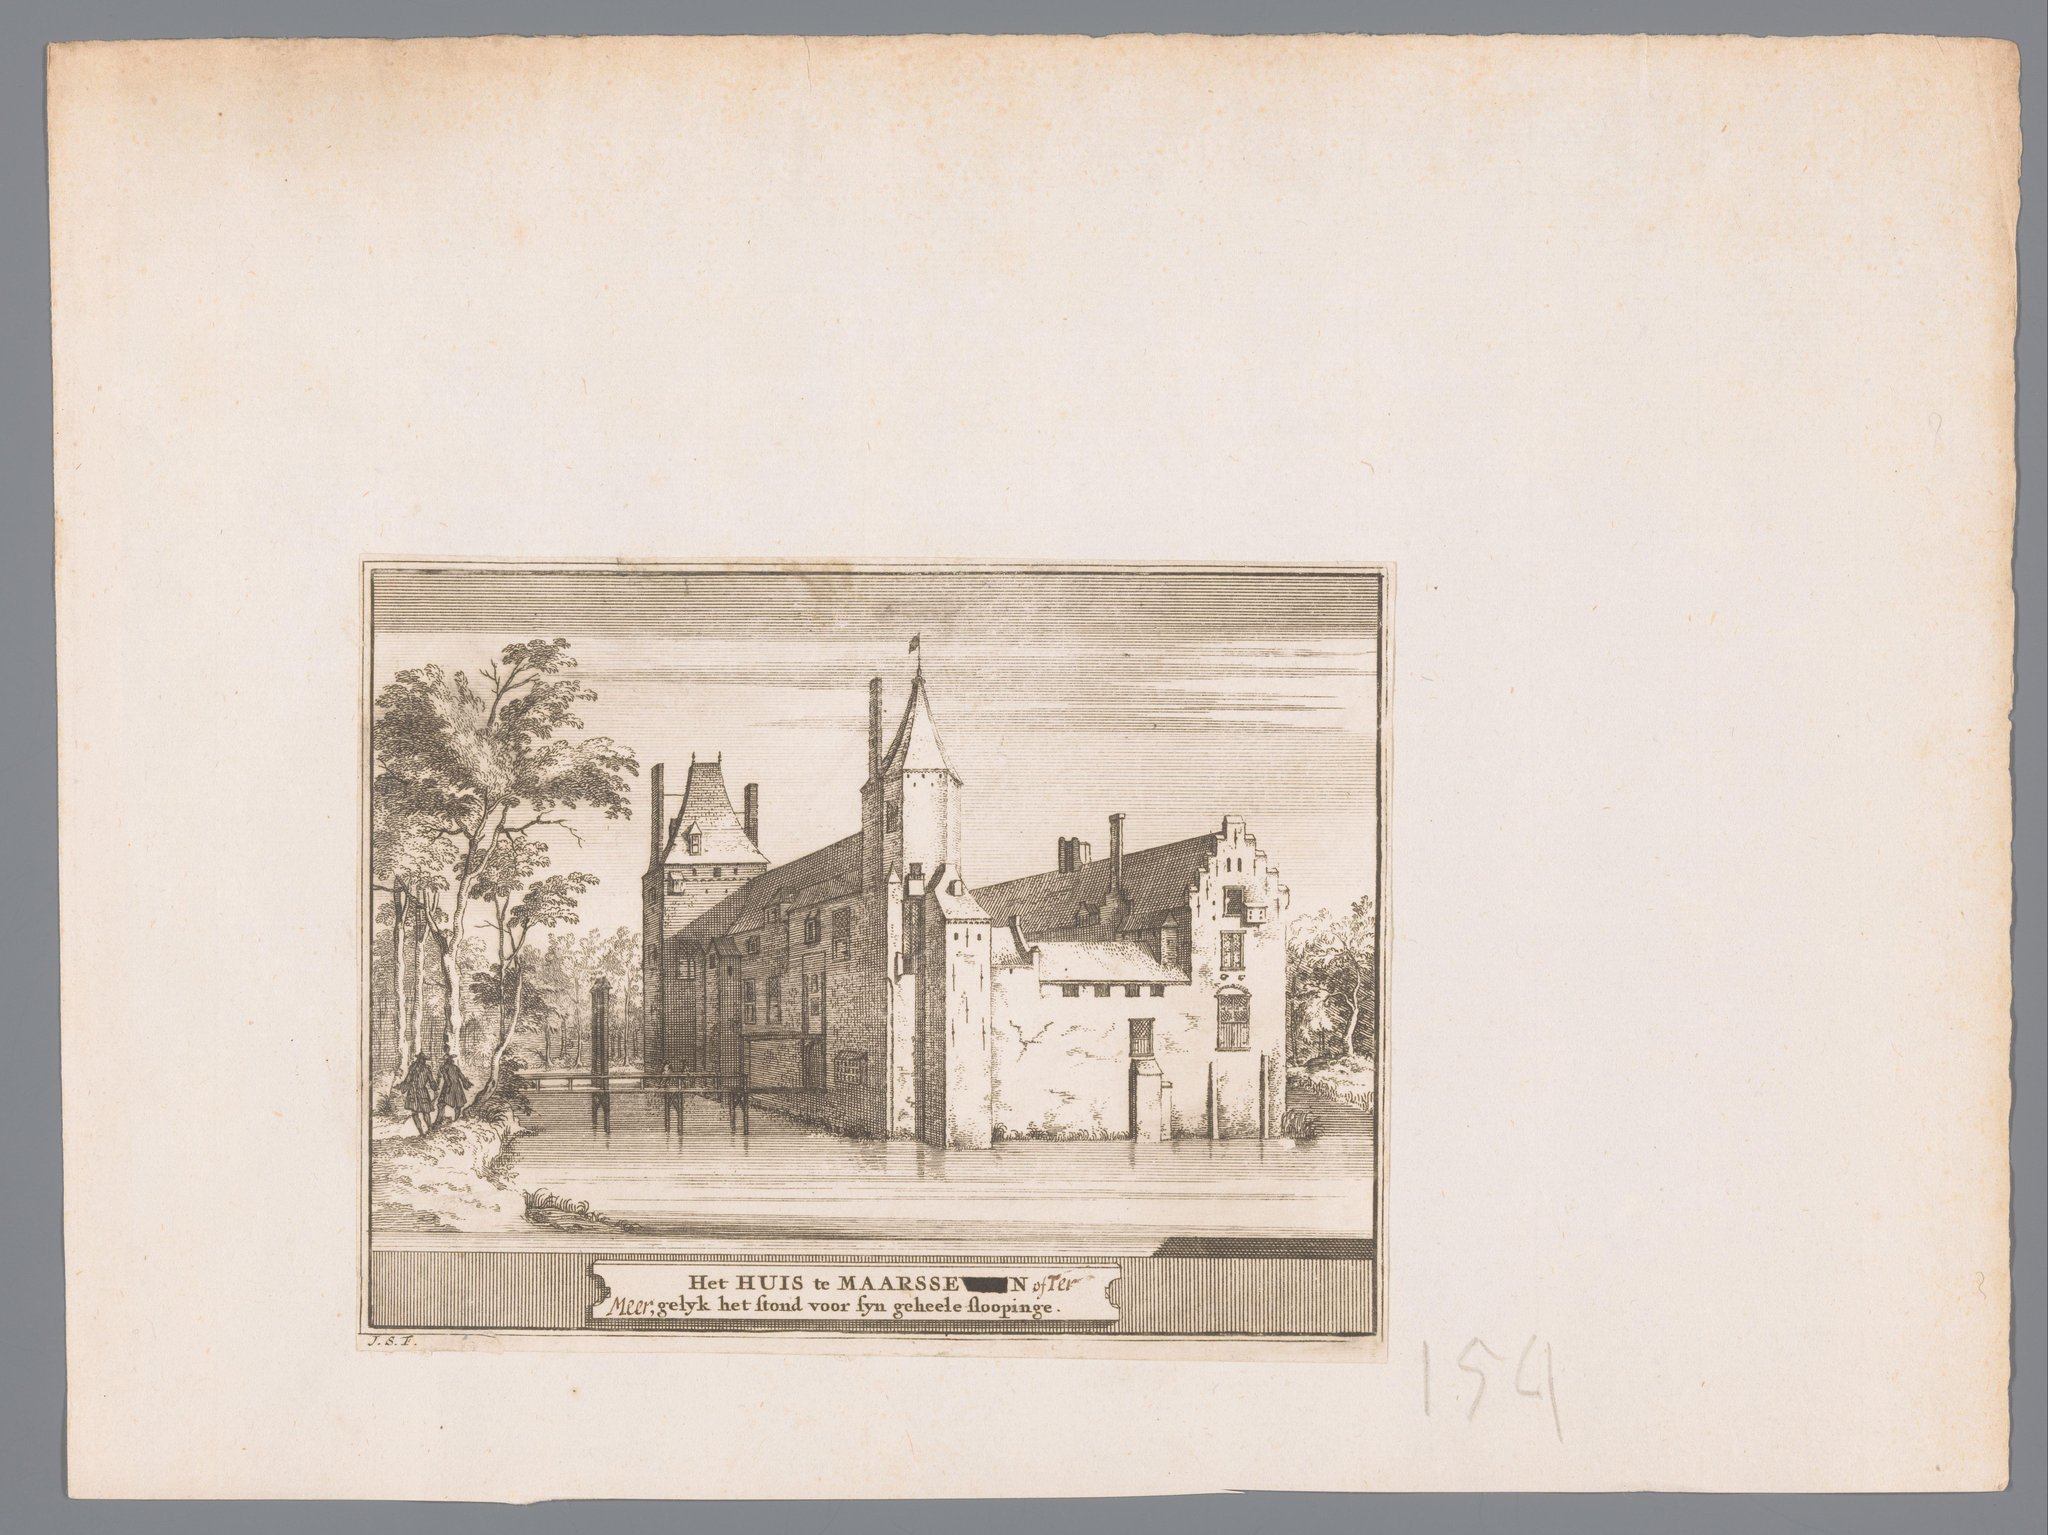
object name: print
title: Gezicht op Huis Ter Meer te Maarssen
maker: jacobus schijnvoet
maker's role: draughtsman, print maker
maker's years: 1685-1743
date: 1711-1774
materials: paper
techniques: etching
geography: amsterdam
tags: castle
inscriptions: inscription: ‘of Ter Meer’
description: Prent opgenomen in: Smids, Ludolph. Schatkamer der Nederlandsse[!] oudheden; of Woordenboek, behelsende Nederlands steden, Amsterdam: Pieter de Coup, 1711. Verscheen tevens in de heruitgave van voorgenoemd werk in 1737 en 1774. In 1721 verscheen er een uitgave met alleen de prenten: Nederlandsche oudheden, bestaande in zestig verbeeldingen (...) gelegen in Holland, 't Sticht van Utrecht en Gelderland enz. Amsterdam: Hendrik Bosch, 1721.